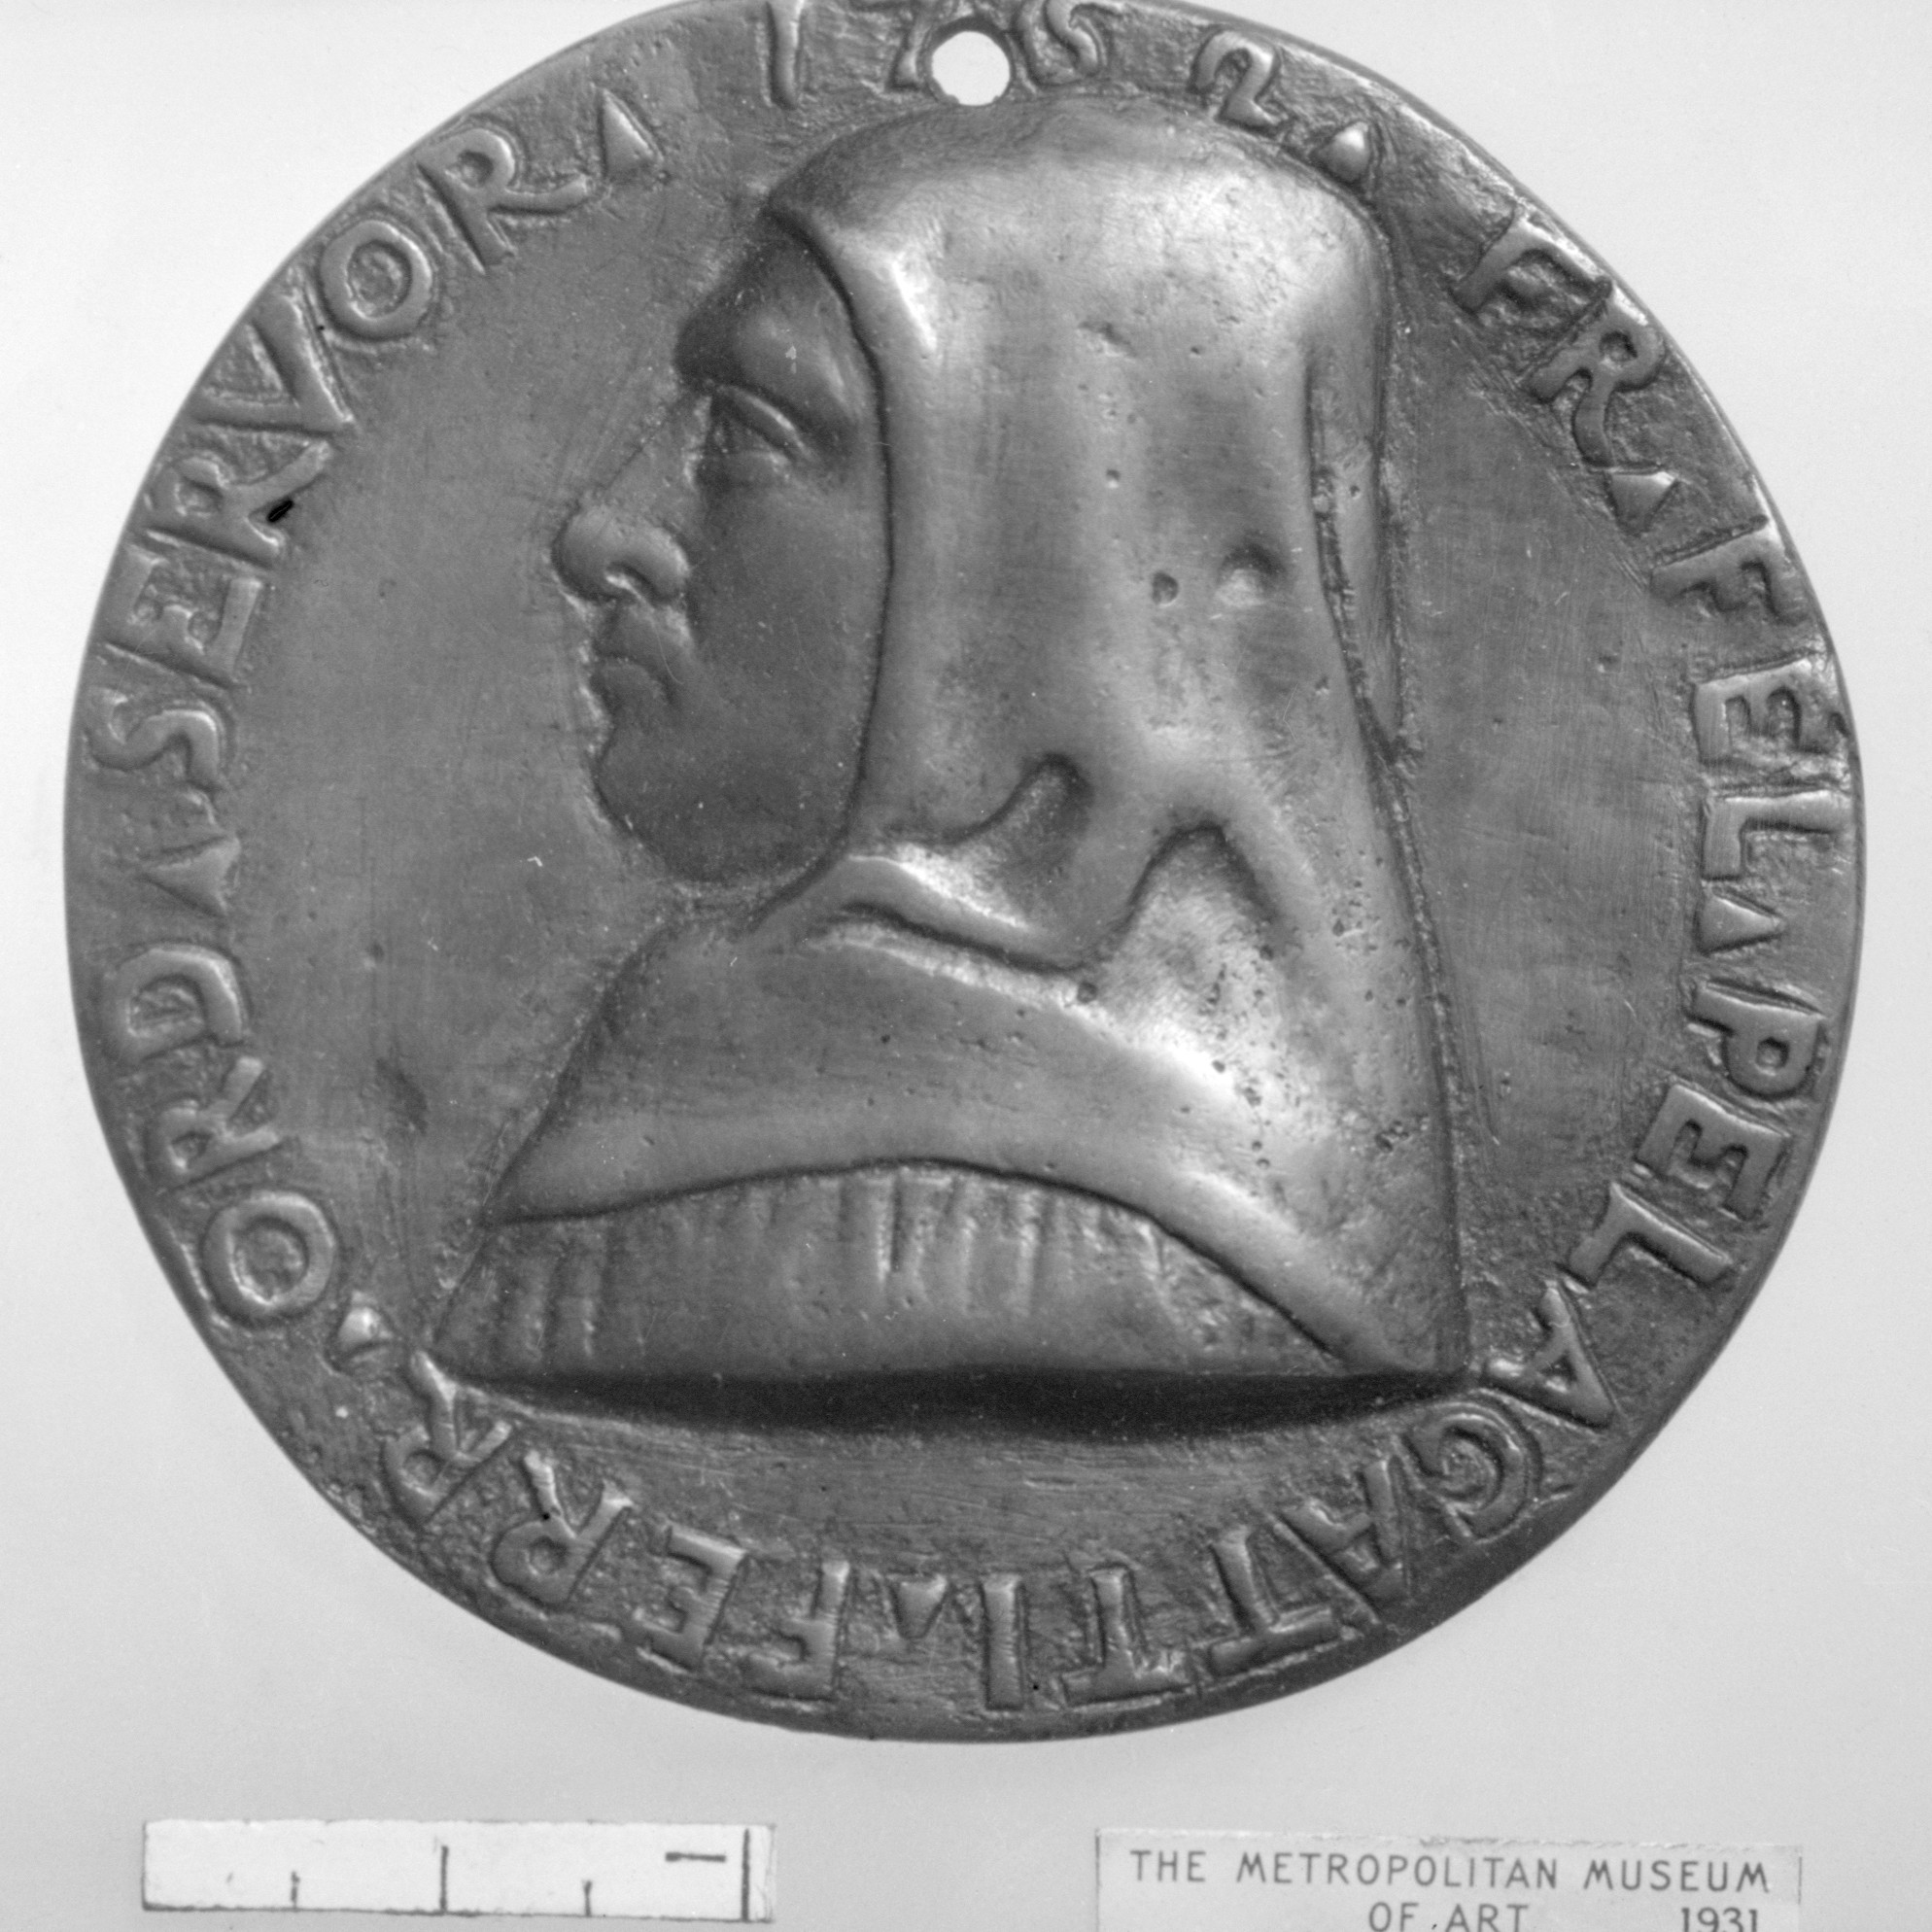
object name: medal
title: Timoteo Moffei, Canon of Verona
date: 1401-1500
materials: bronze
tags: men,profiles